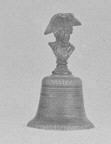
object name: handbell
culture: european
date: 1801-1900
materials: metal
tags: men